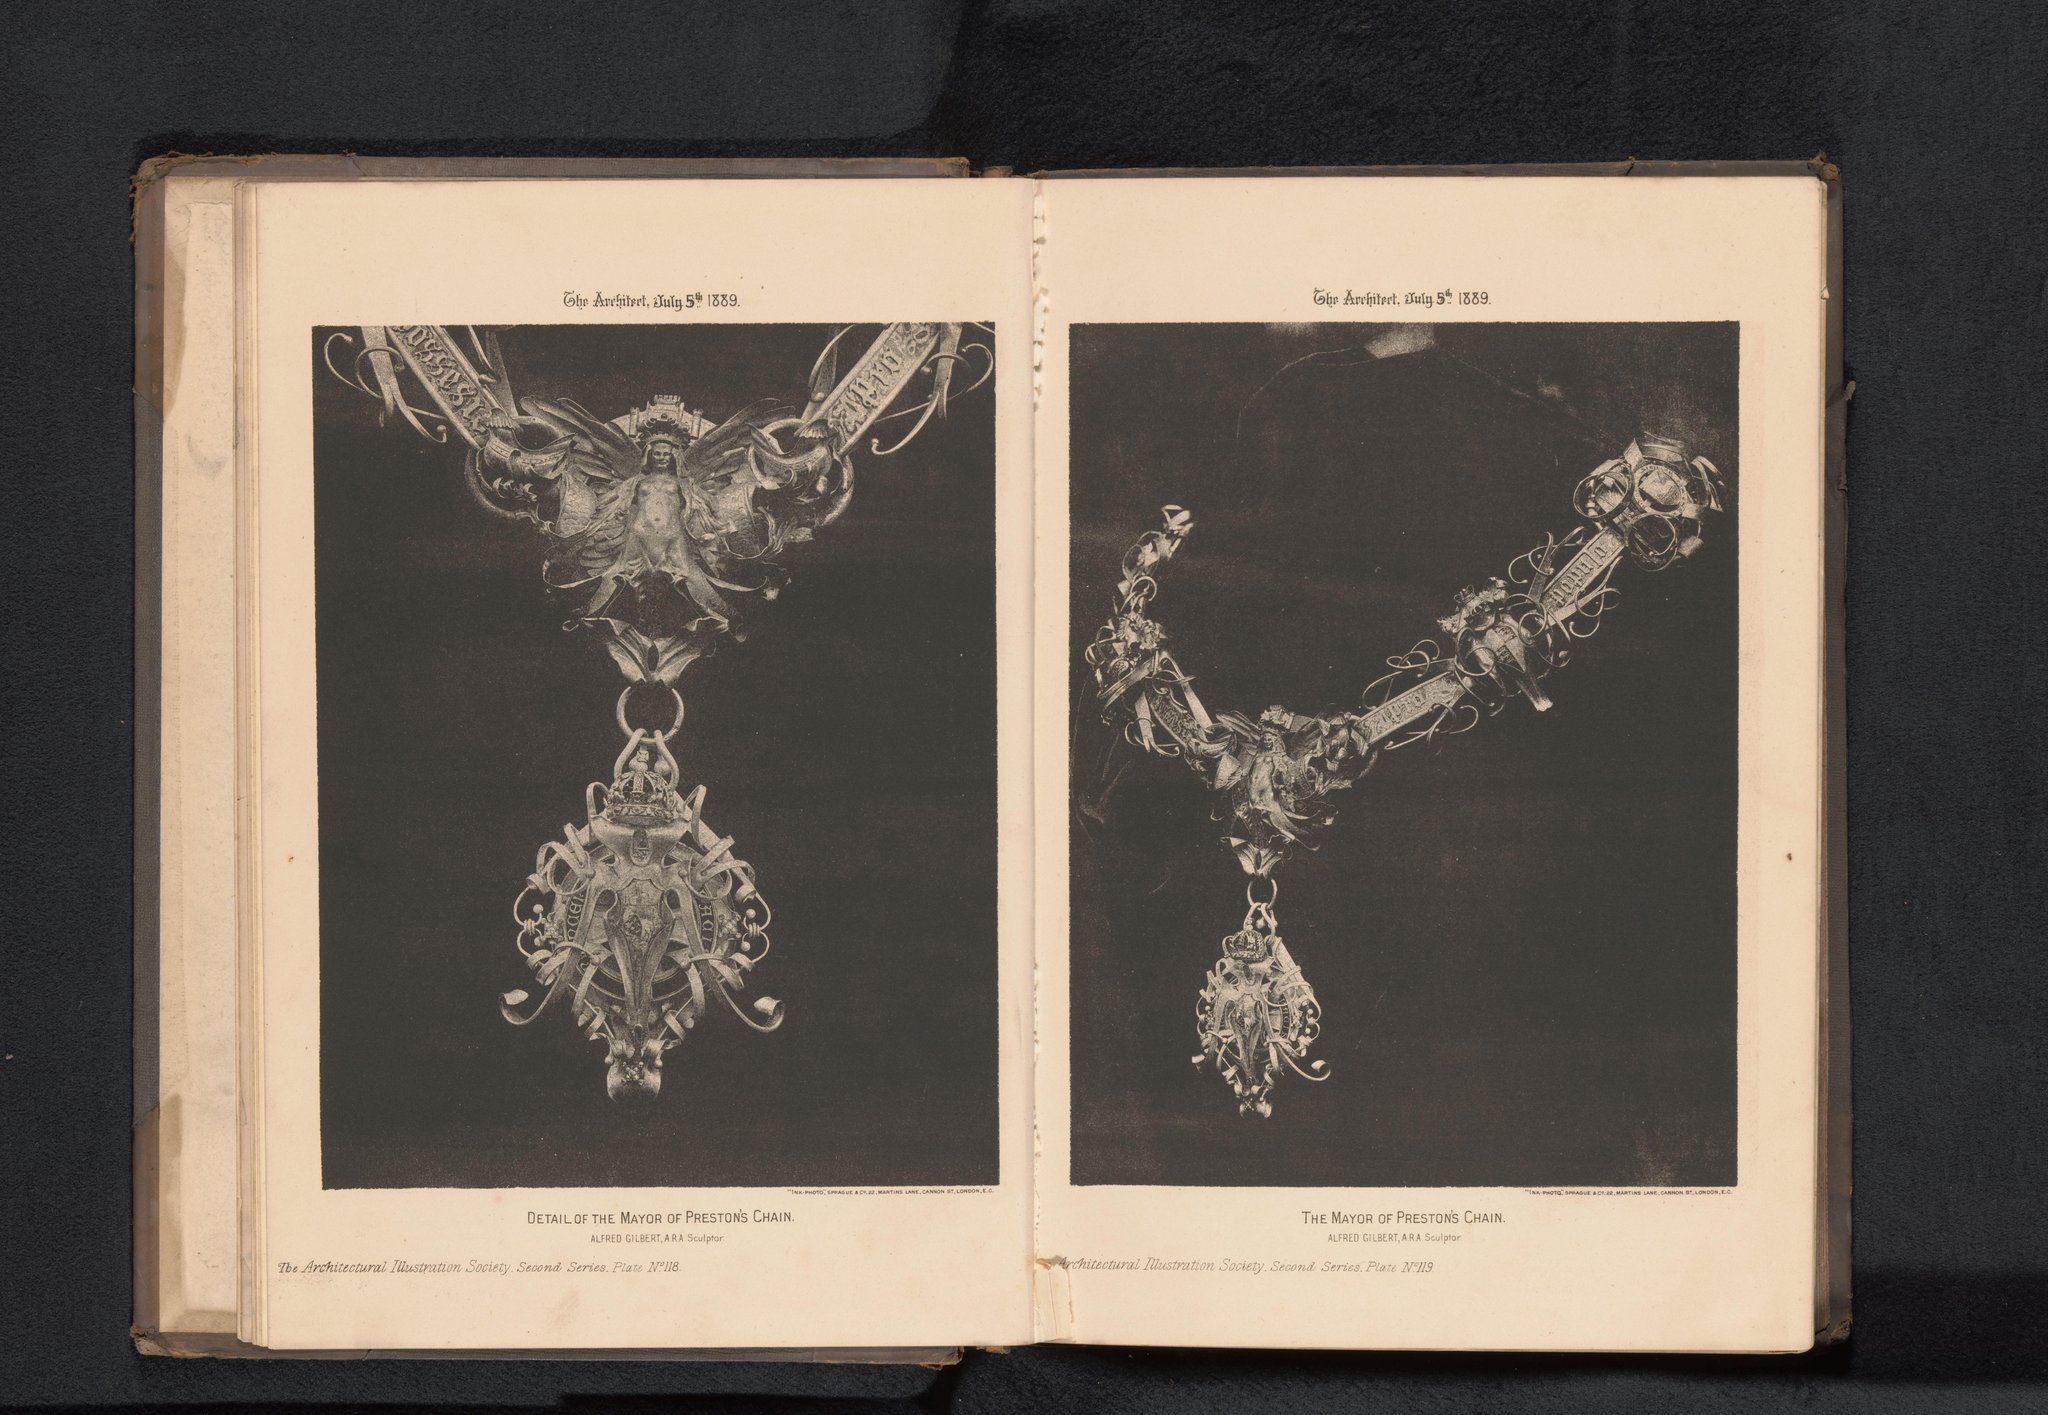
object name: page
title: Detail van de ambtsketen van de burgemeester van Preston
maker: Anonymous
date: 1884-1889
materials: paper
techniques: photolithography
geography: london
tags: necklace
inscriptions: inscription: ‘Alfred Gilbert, A.R.A. Sculptor/ The Architectural Illustration Society. Second Series Plate No118.’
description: Prent op tweede ongenummerde pagina na pagina 8.